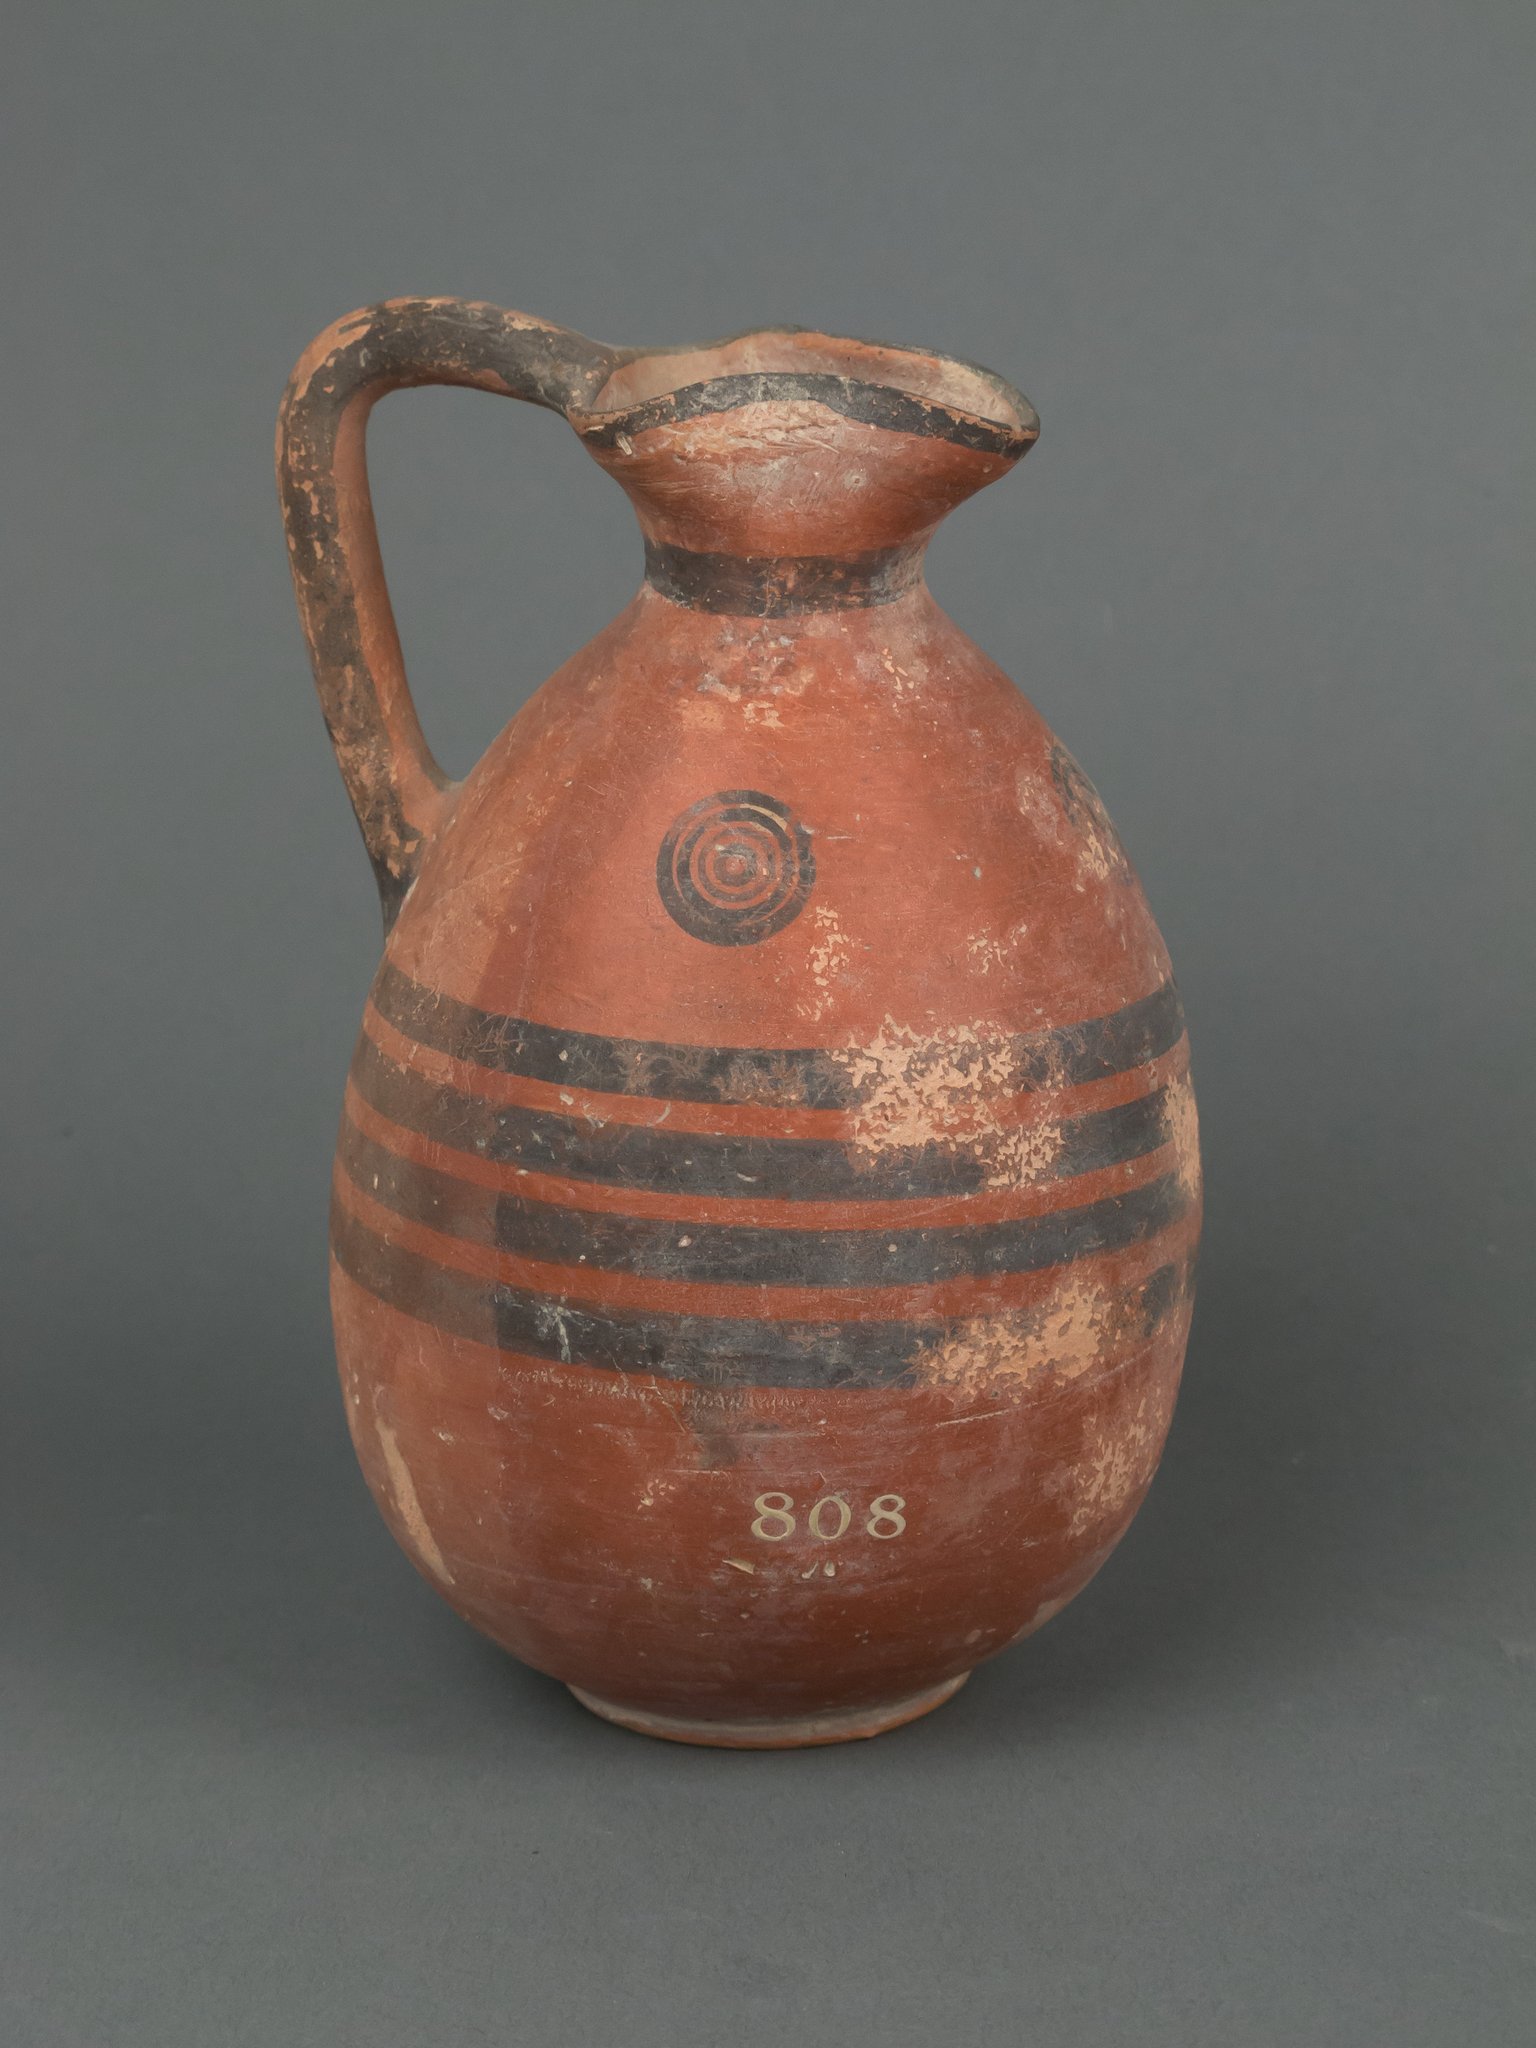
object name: jug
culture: cypriot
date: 750-600 BCE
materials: terracotta